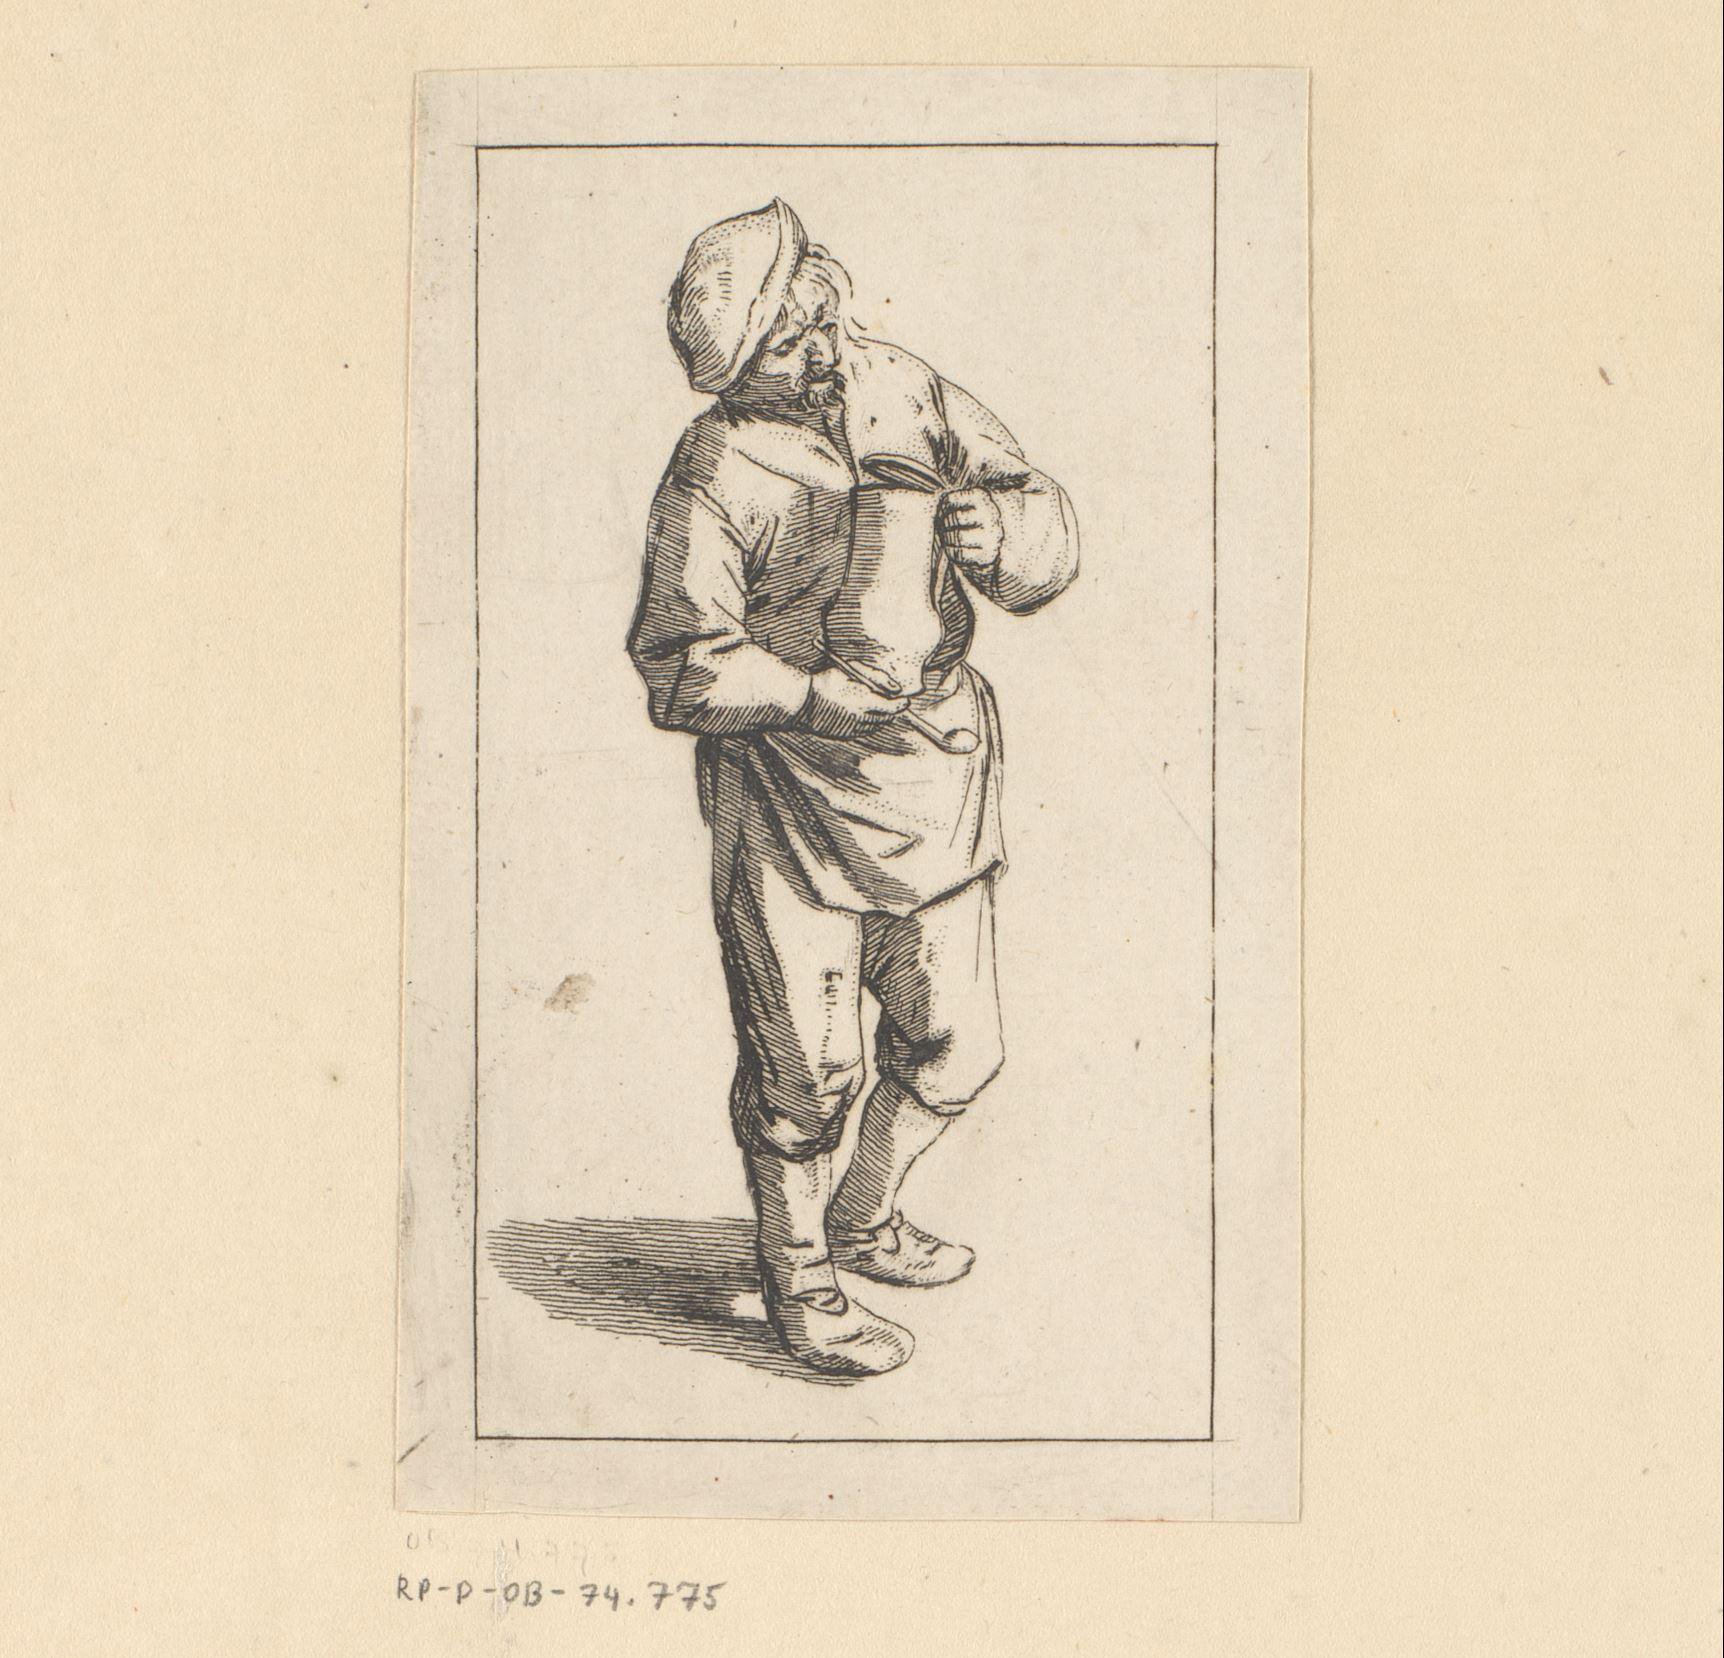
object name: print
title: Man met kan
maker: Anonymous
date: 1700-1730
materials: paper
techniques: etching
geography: france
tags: container of ceramics: jar, jug, pot, vase (+ metal), adult man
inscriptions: collector's mark: Lugt 240